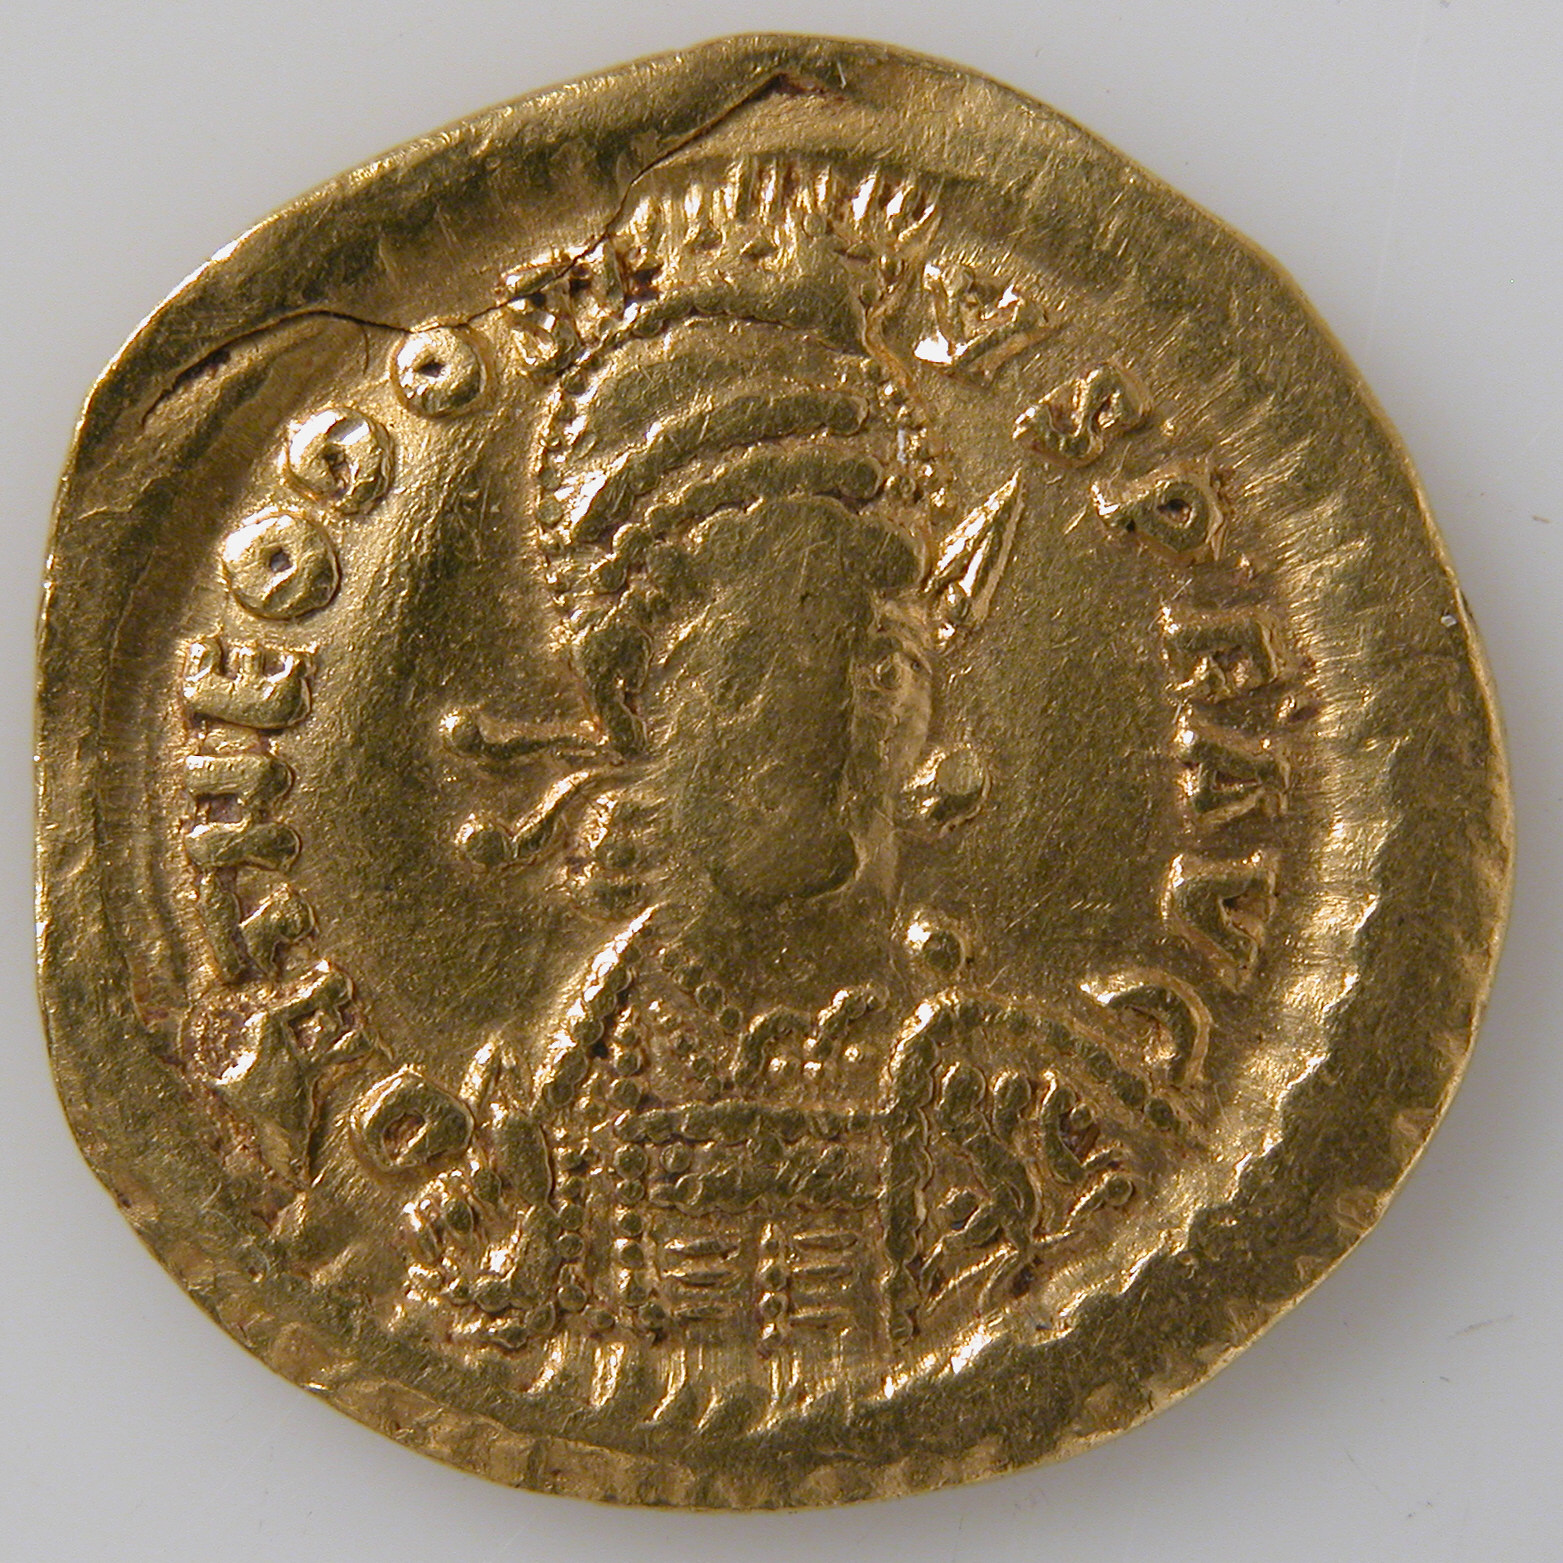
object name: solidus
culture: byzantine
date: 408-518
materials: gold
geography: constantinople